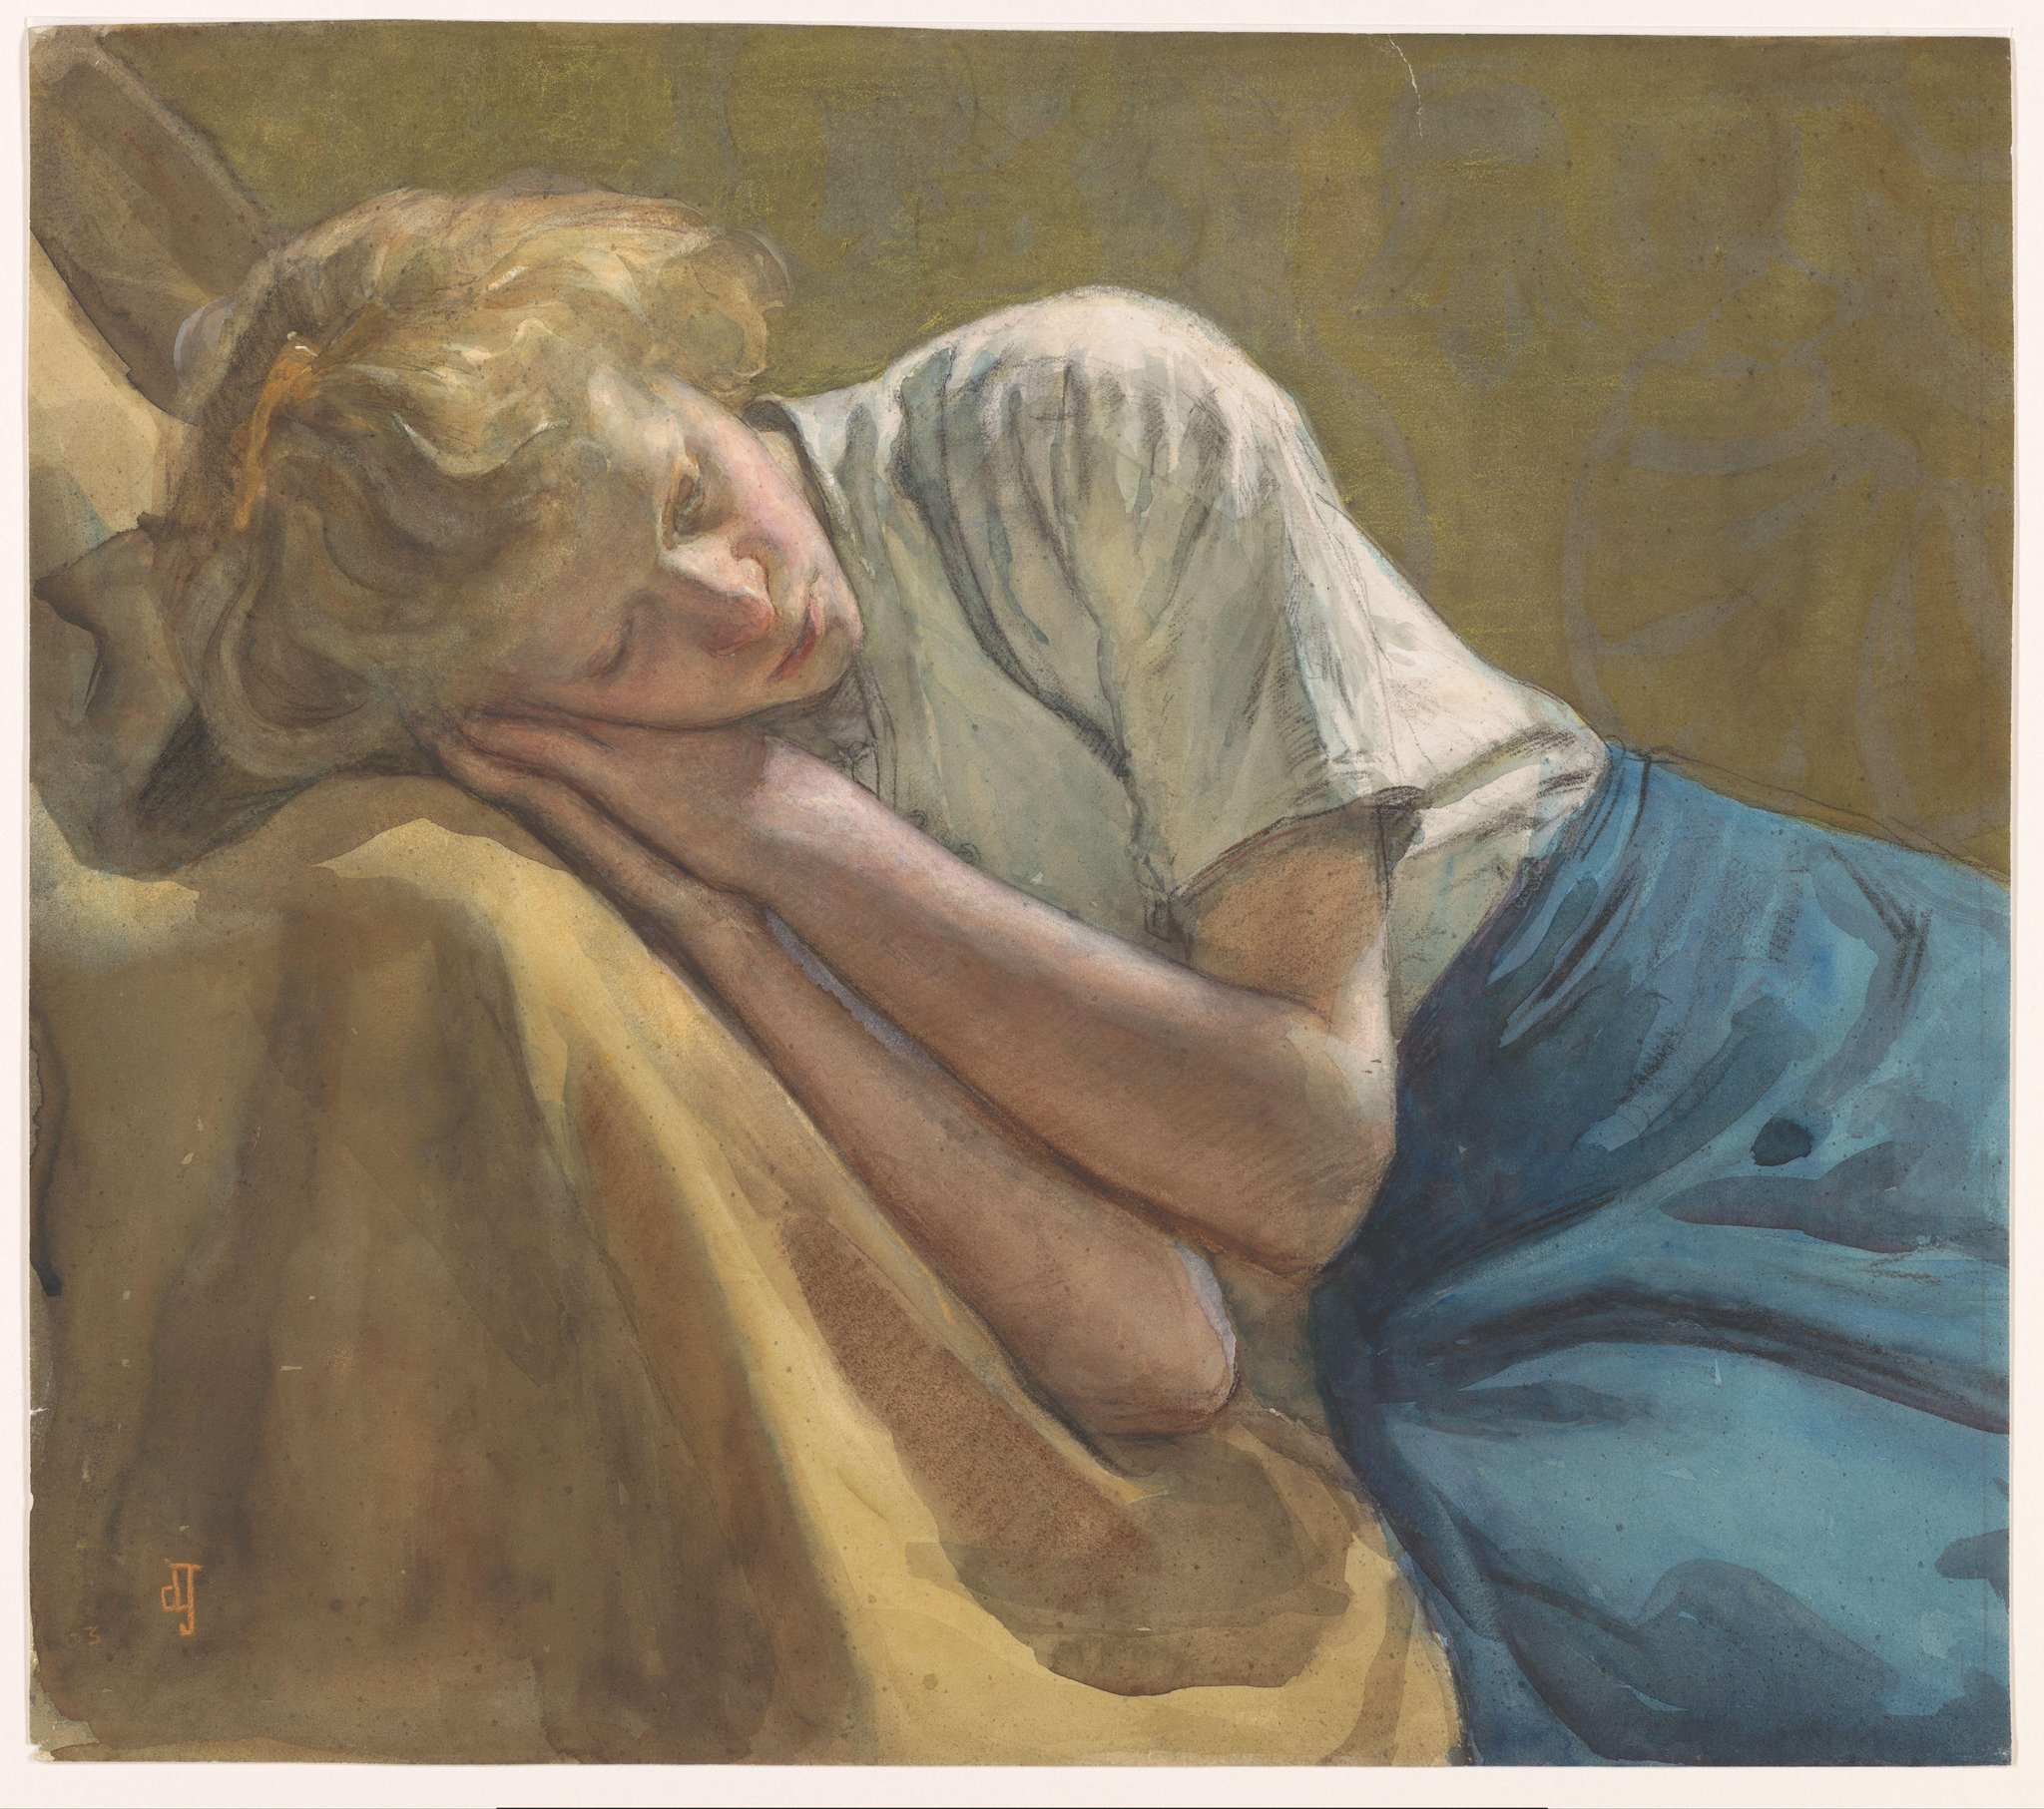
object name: drawing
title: Rustend meisje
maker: johan antonie de jonge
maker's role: draughtsman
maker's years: 1864-1927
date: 1903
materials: charcoal, paper, watercolor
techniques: brush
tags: adolescent, young woman, maiden, resting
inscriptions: monogram and date: ‘03 dJ’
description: De huidige titel is door het Rijksmuseum overgenomen van het Instituut Collectie Nederland.